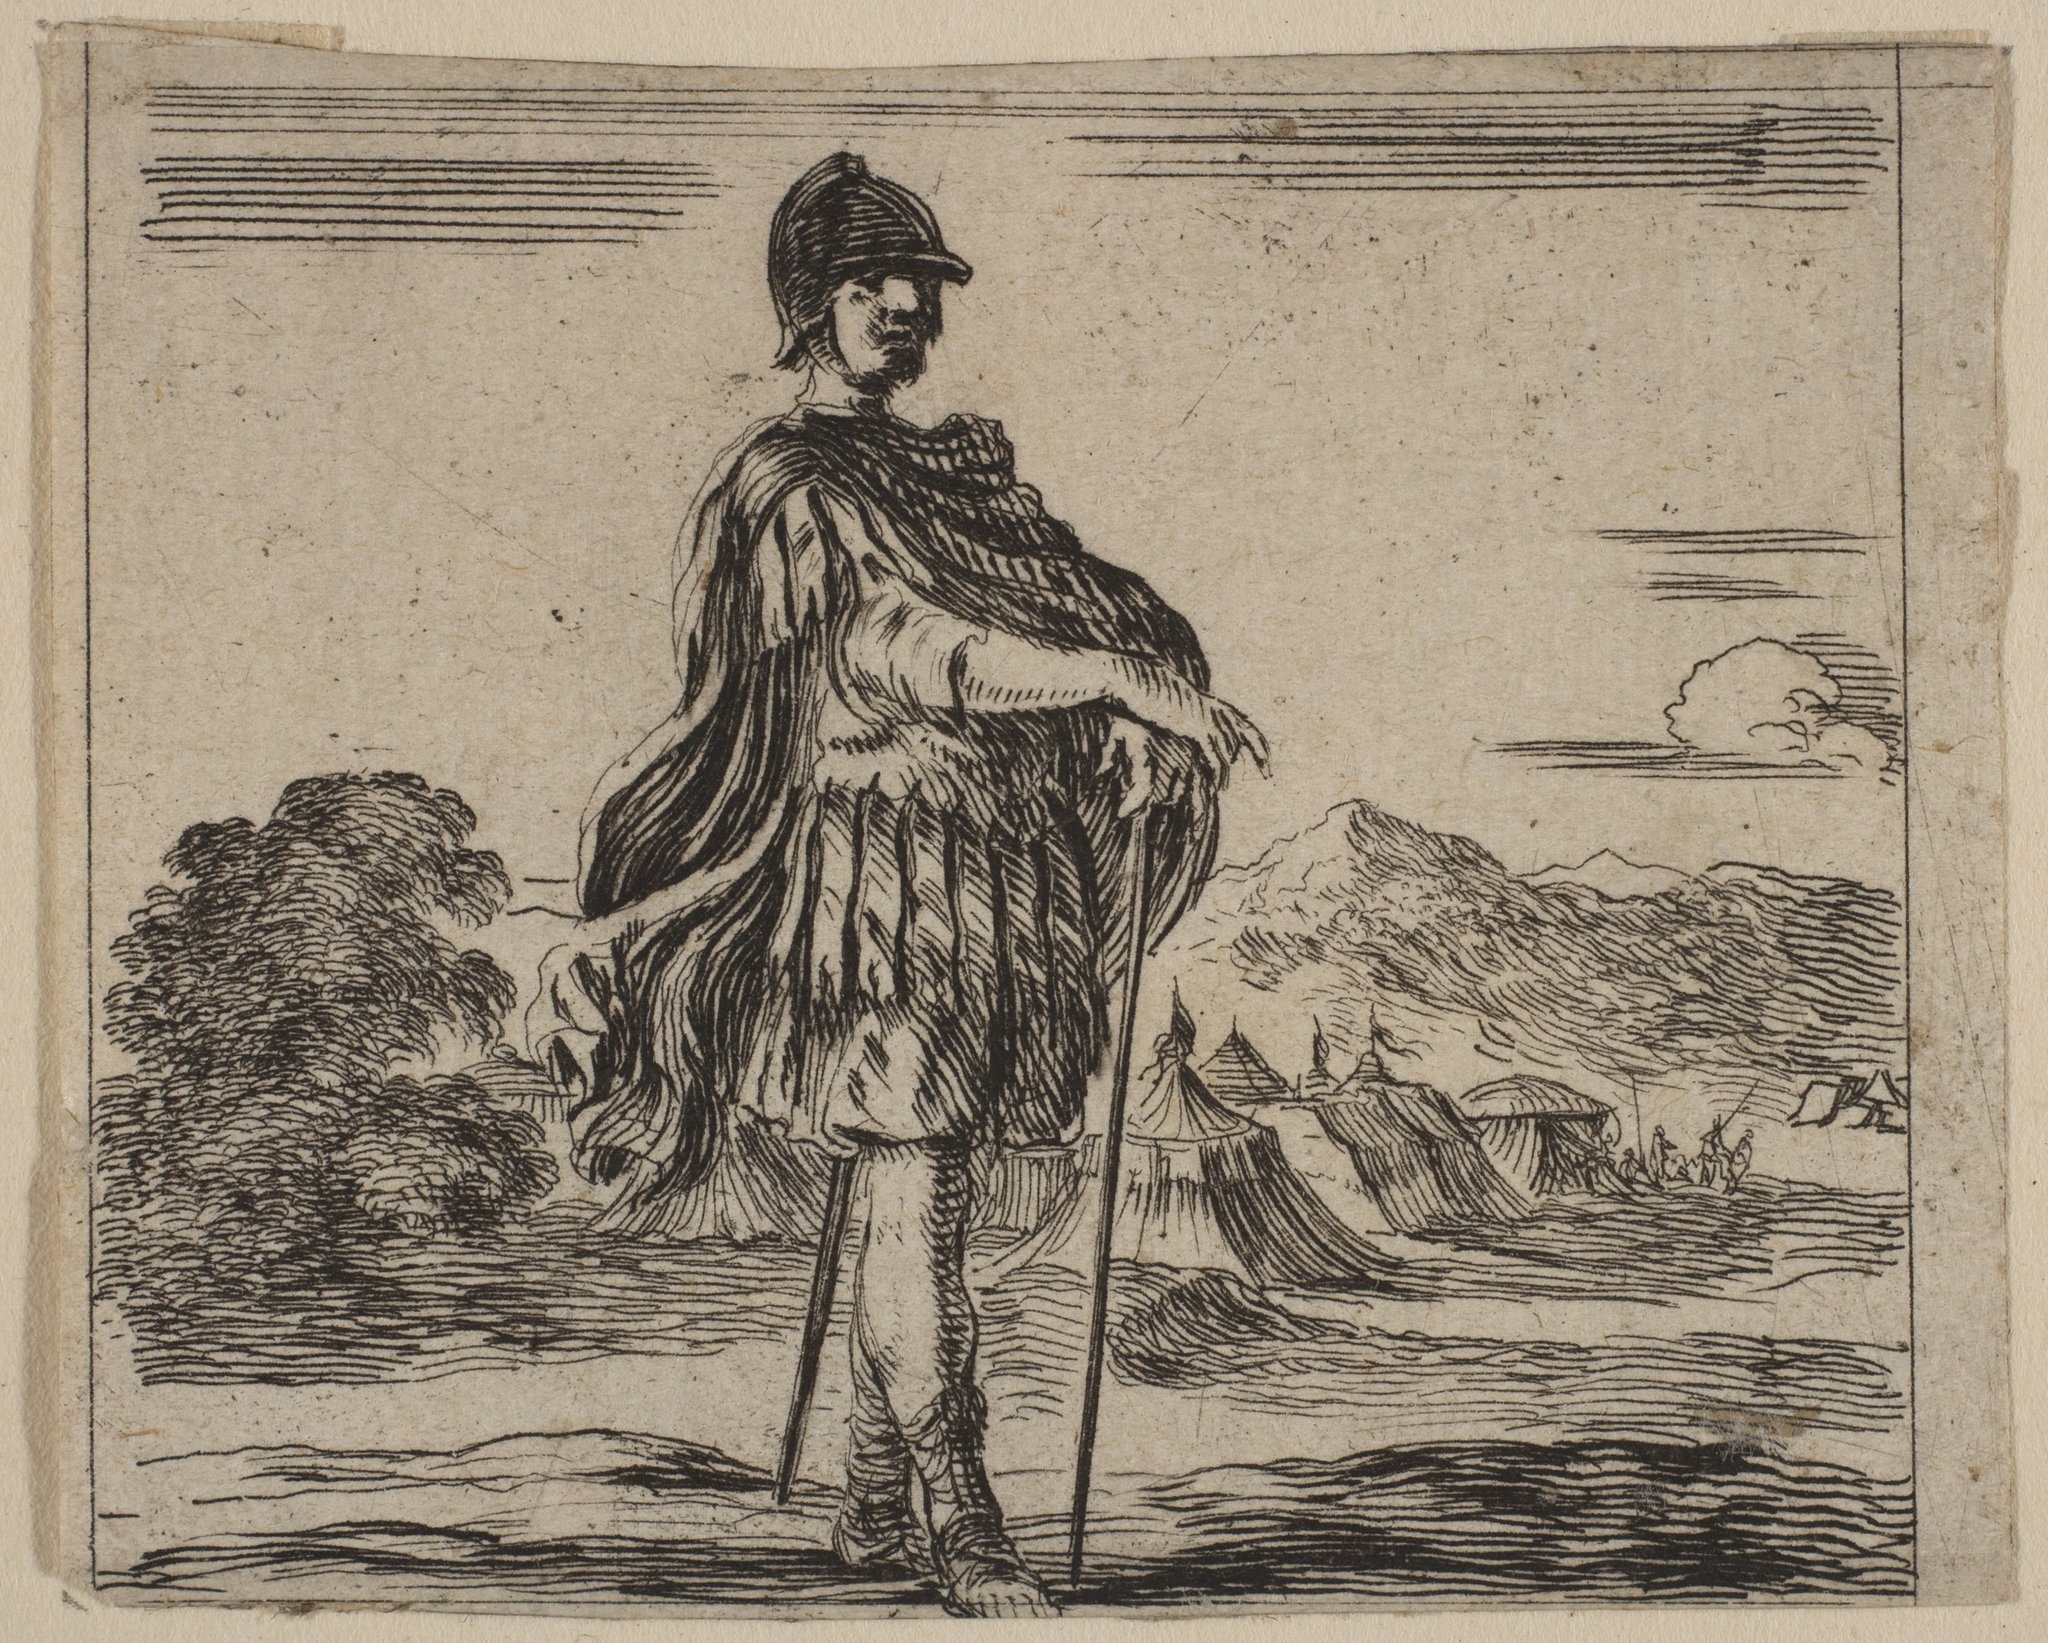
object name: print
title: Mars, from 'Game of Mythology' (Jeu de la Mythologie)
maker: stefano della bella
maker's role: artist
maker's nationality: italian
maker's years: 1610-1664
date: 1644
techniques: etching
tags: tents,mars